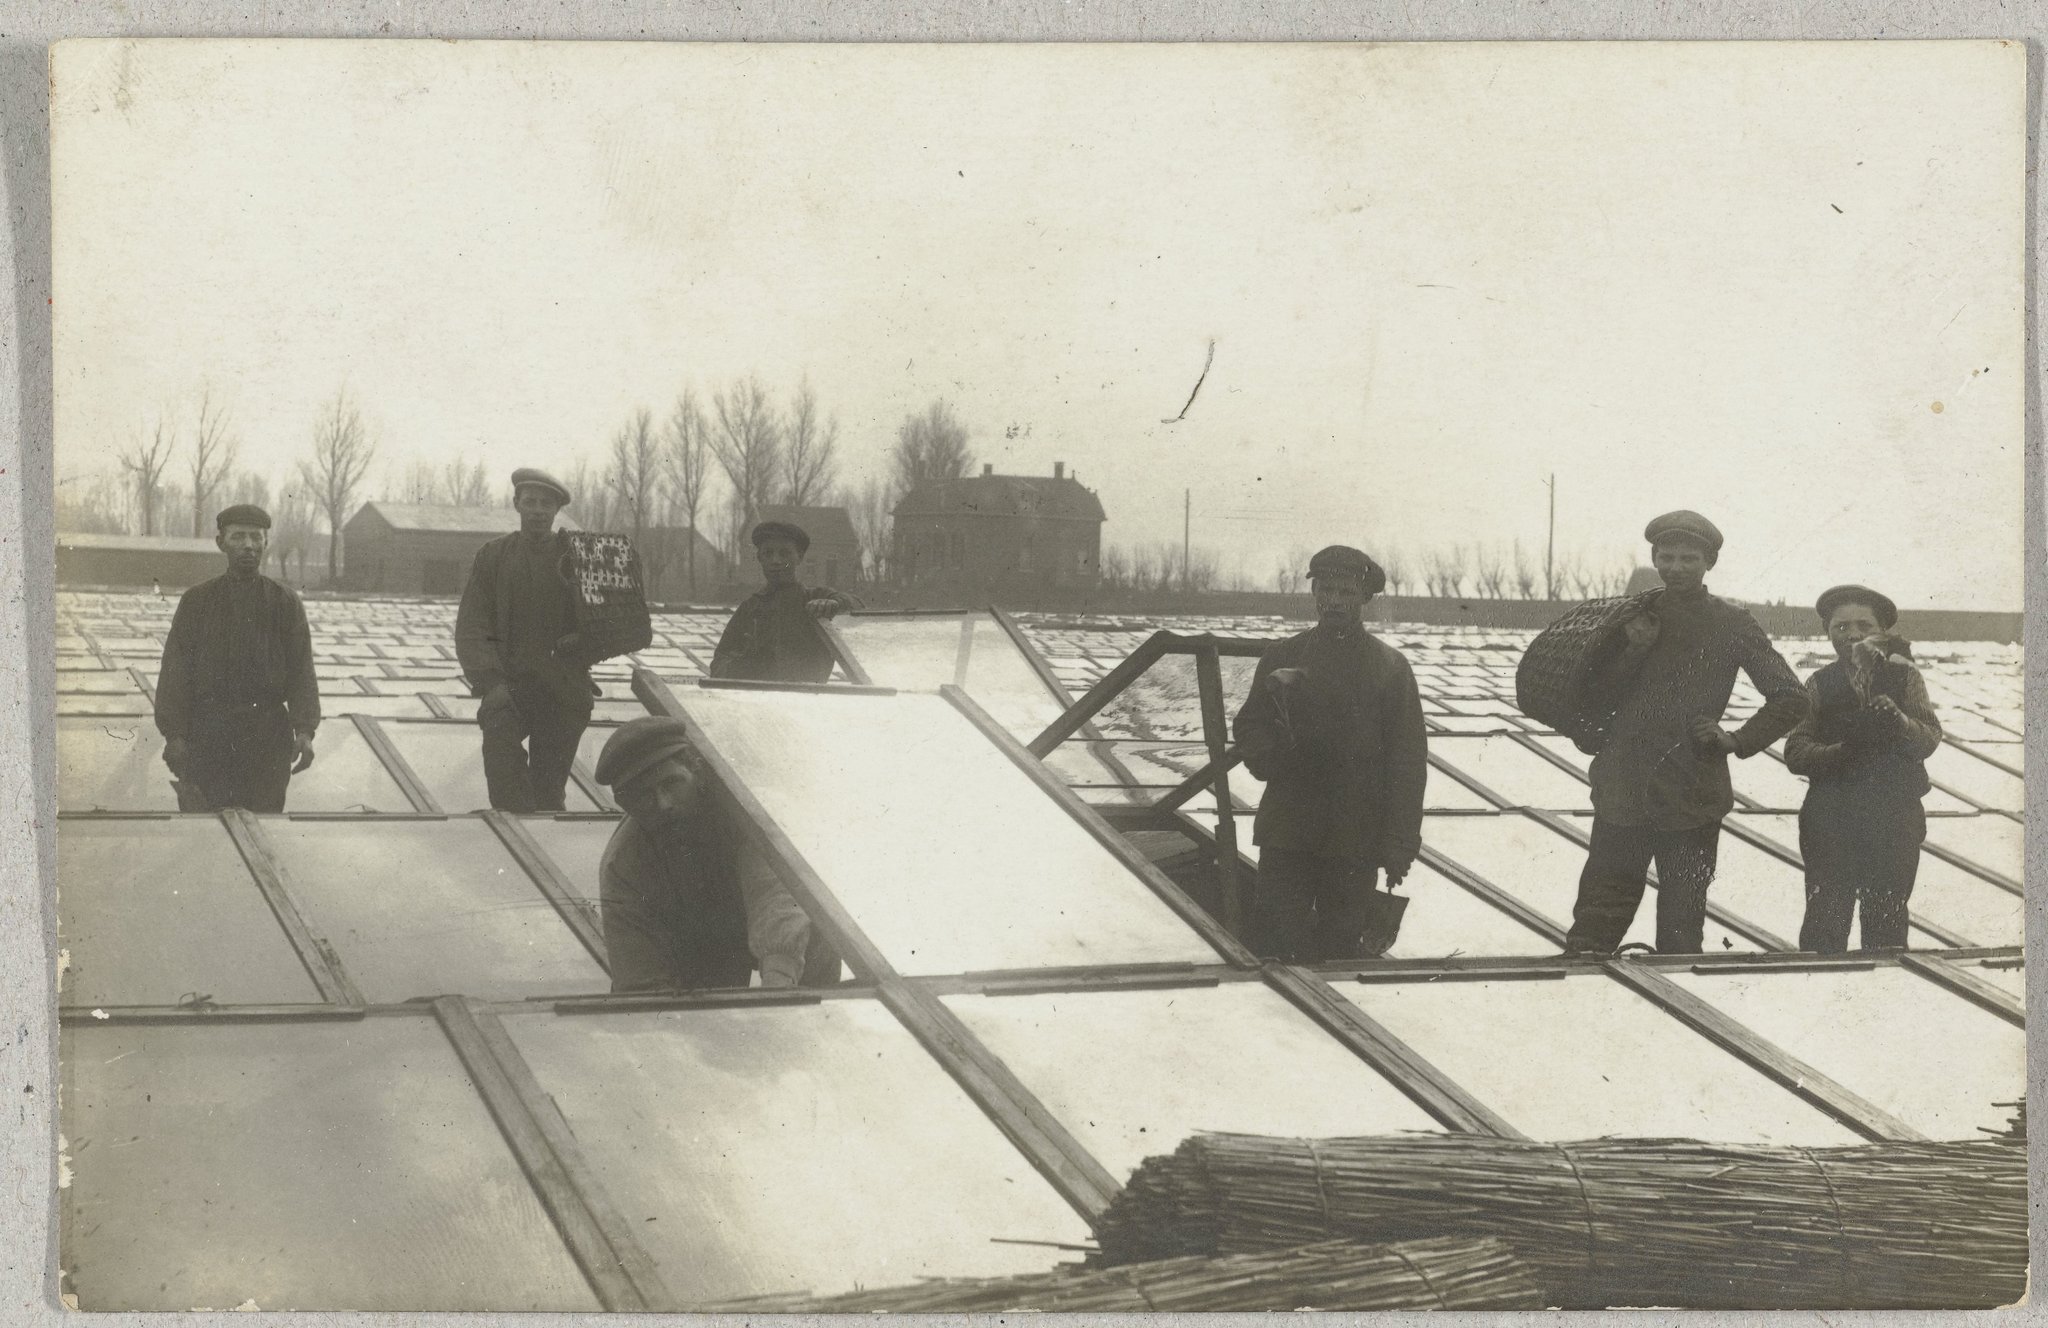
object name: photograph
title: Jongens en mannen werken in lage kassen in een tuin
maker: Anonymous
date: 1890-1925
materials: photographic support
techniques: gelatin silver print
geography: netherlands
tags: working class, labourers